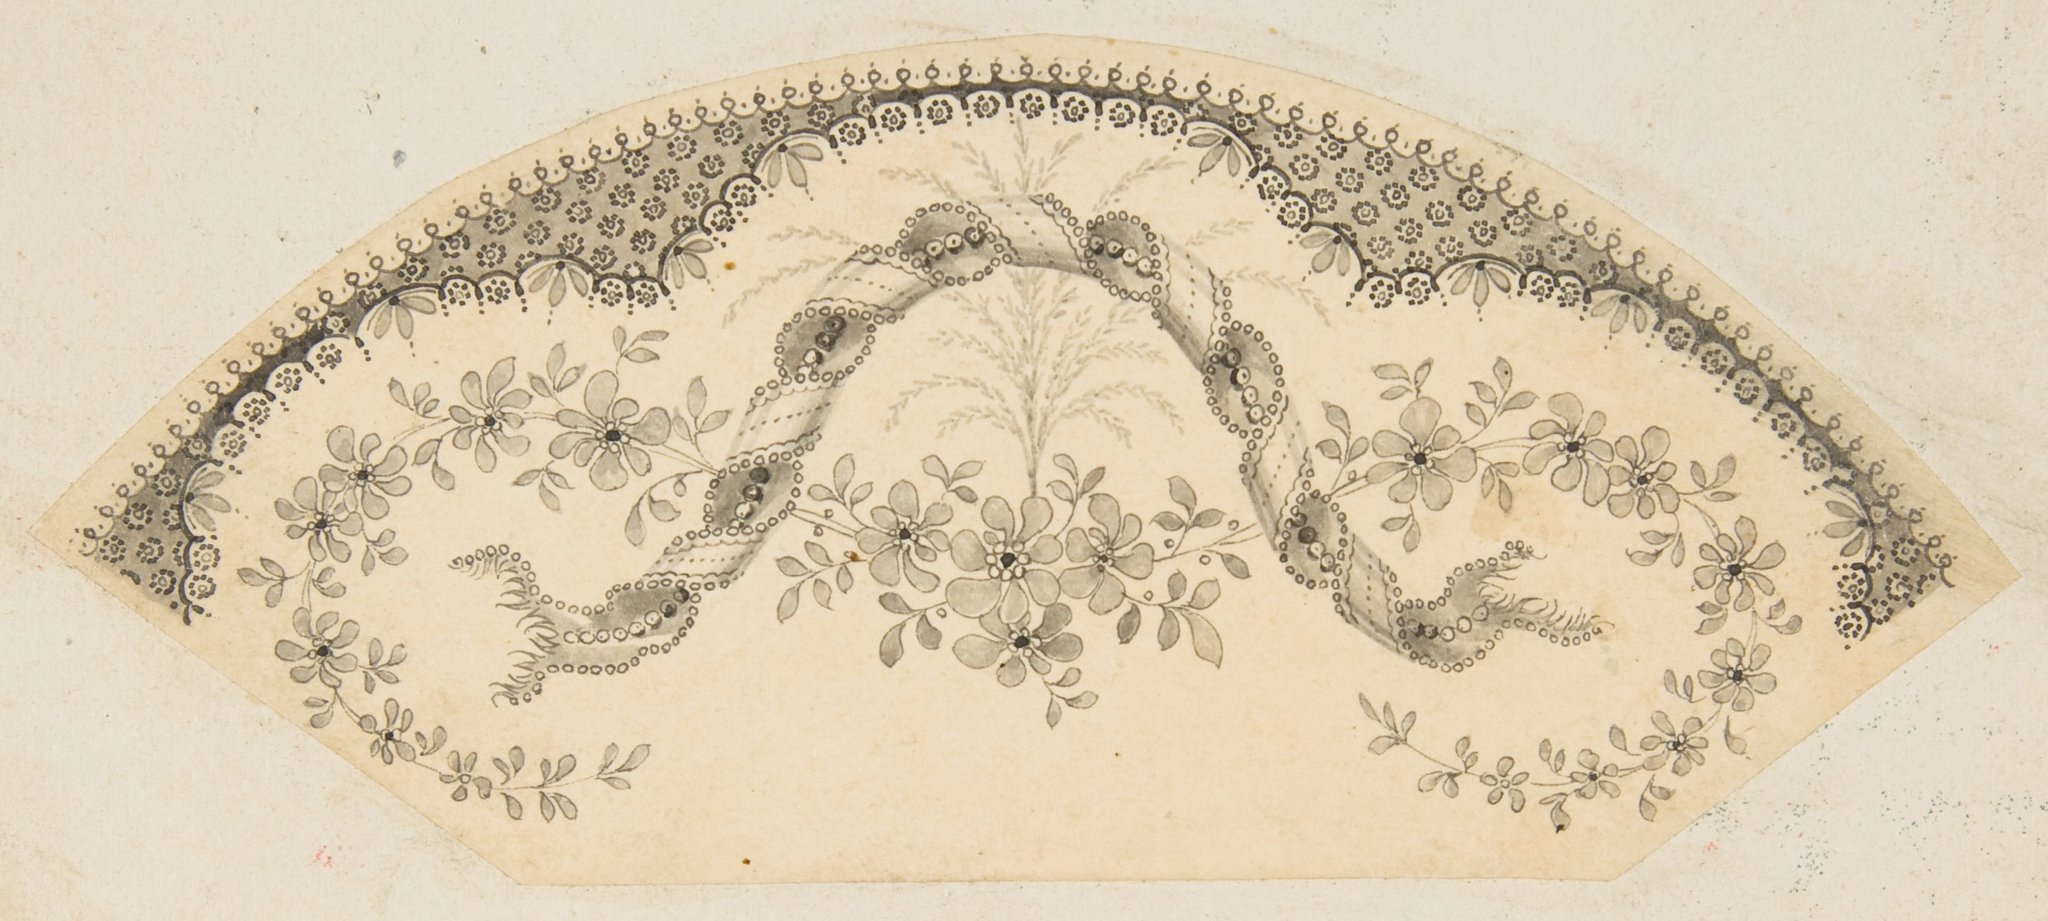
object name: drawing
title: Lace Design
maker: anonymous, french, 19th century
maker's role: artist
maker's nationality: french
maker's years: 1800-1900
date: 1801-1900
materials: ink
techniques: pen, wash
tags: flowers,leaves